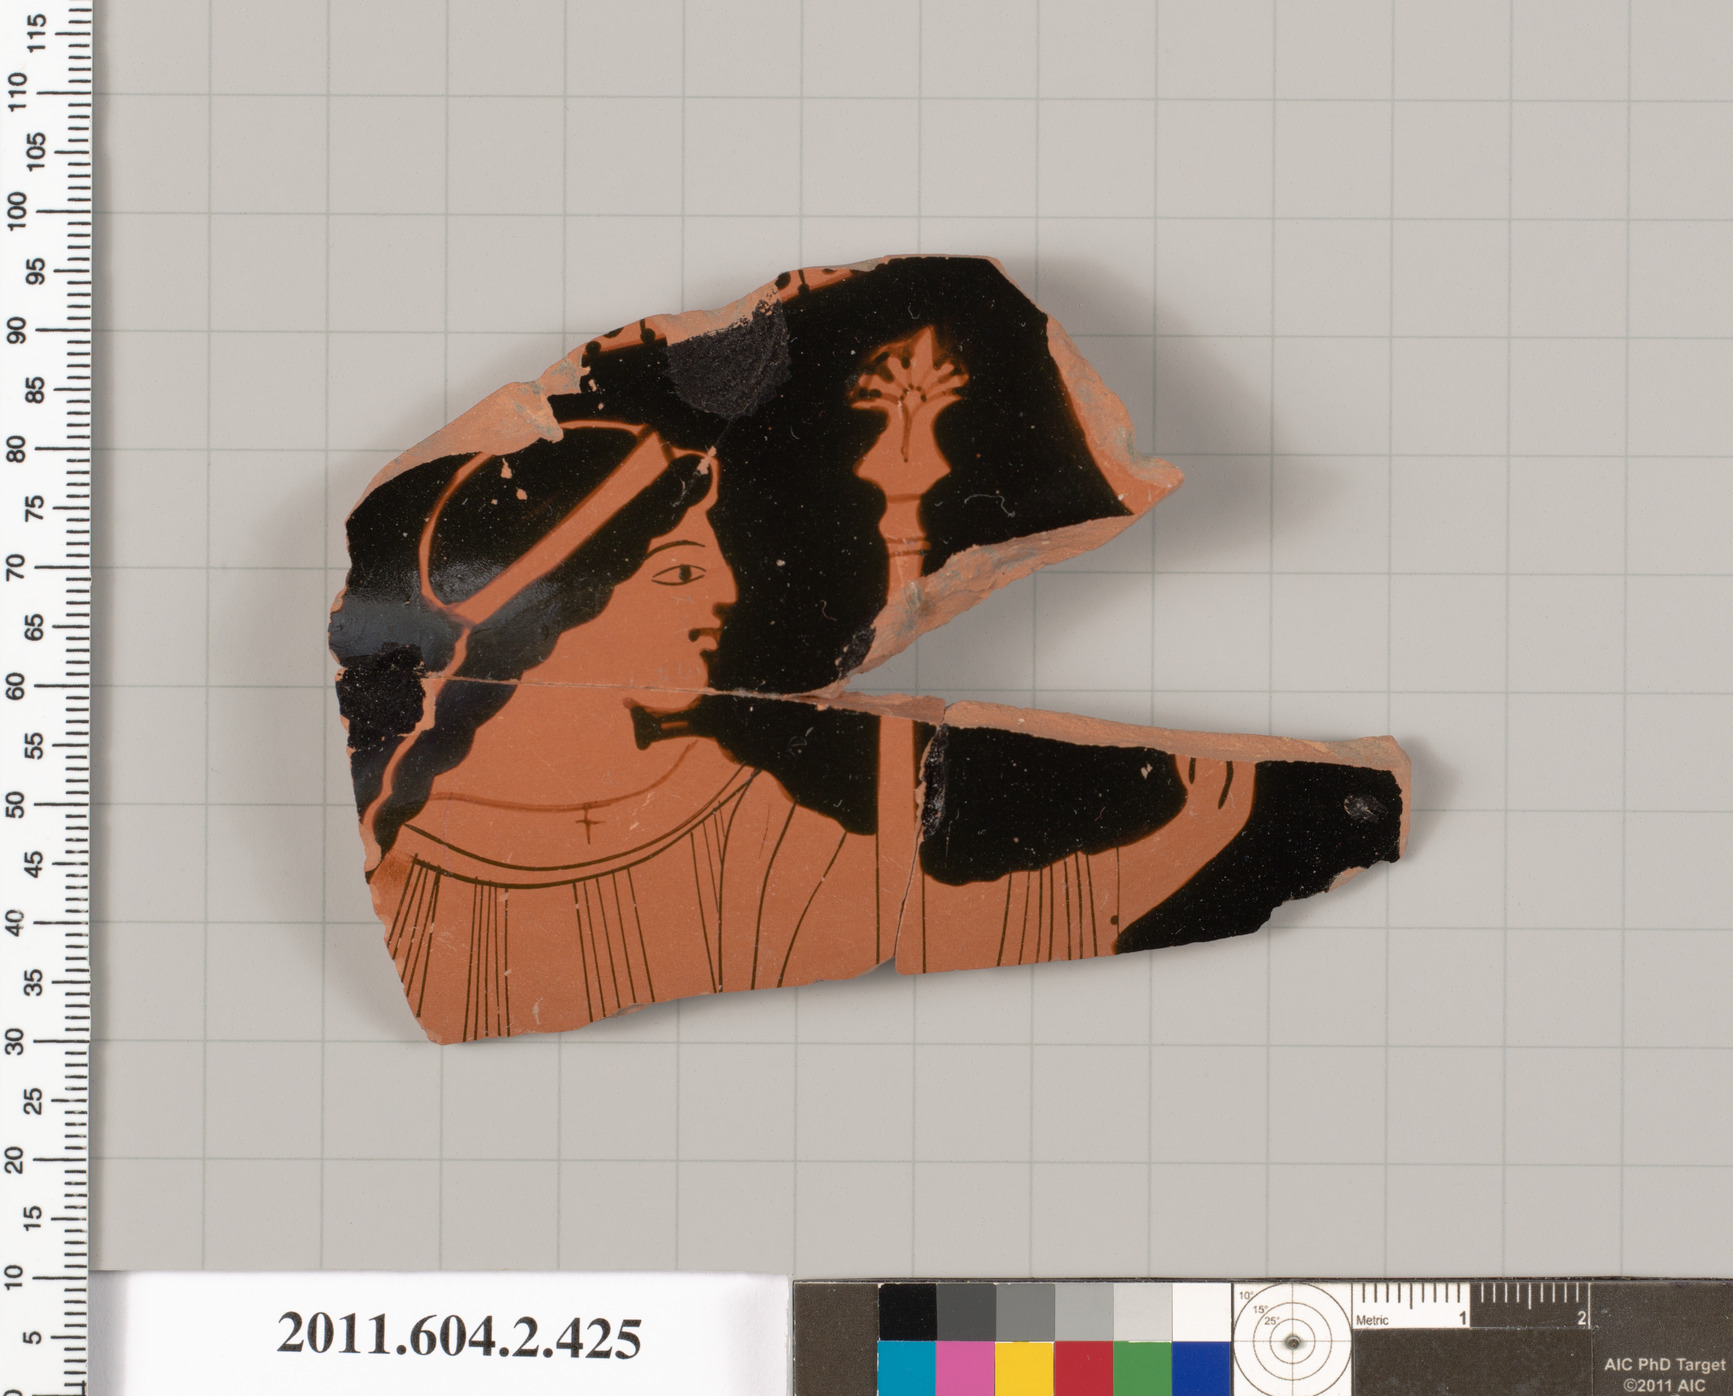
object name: column krater fragment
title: Terracotta fragment of a column-krater (bowl for mixing wine and water)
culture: greek, attic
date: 460-440 BCE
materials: terracotta